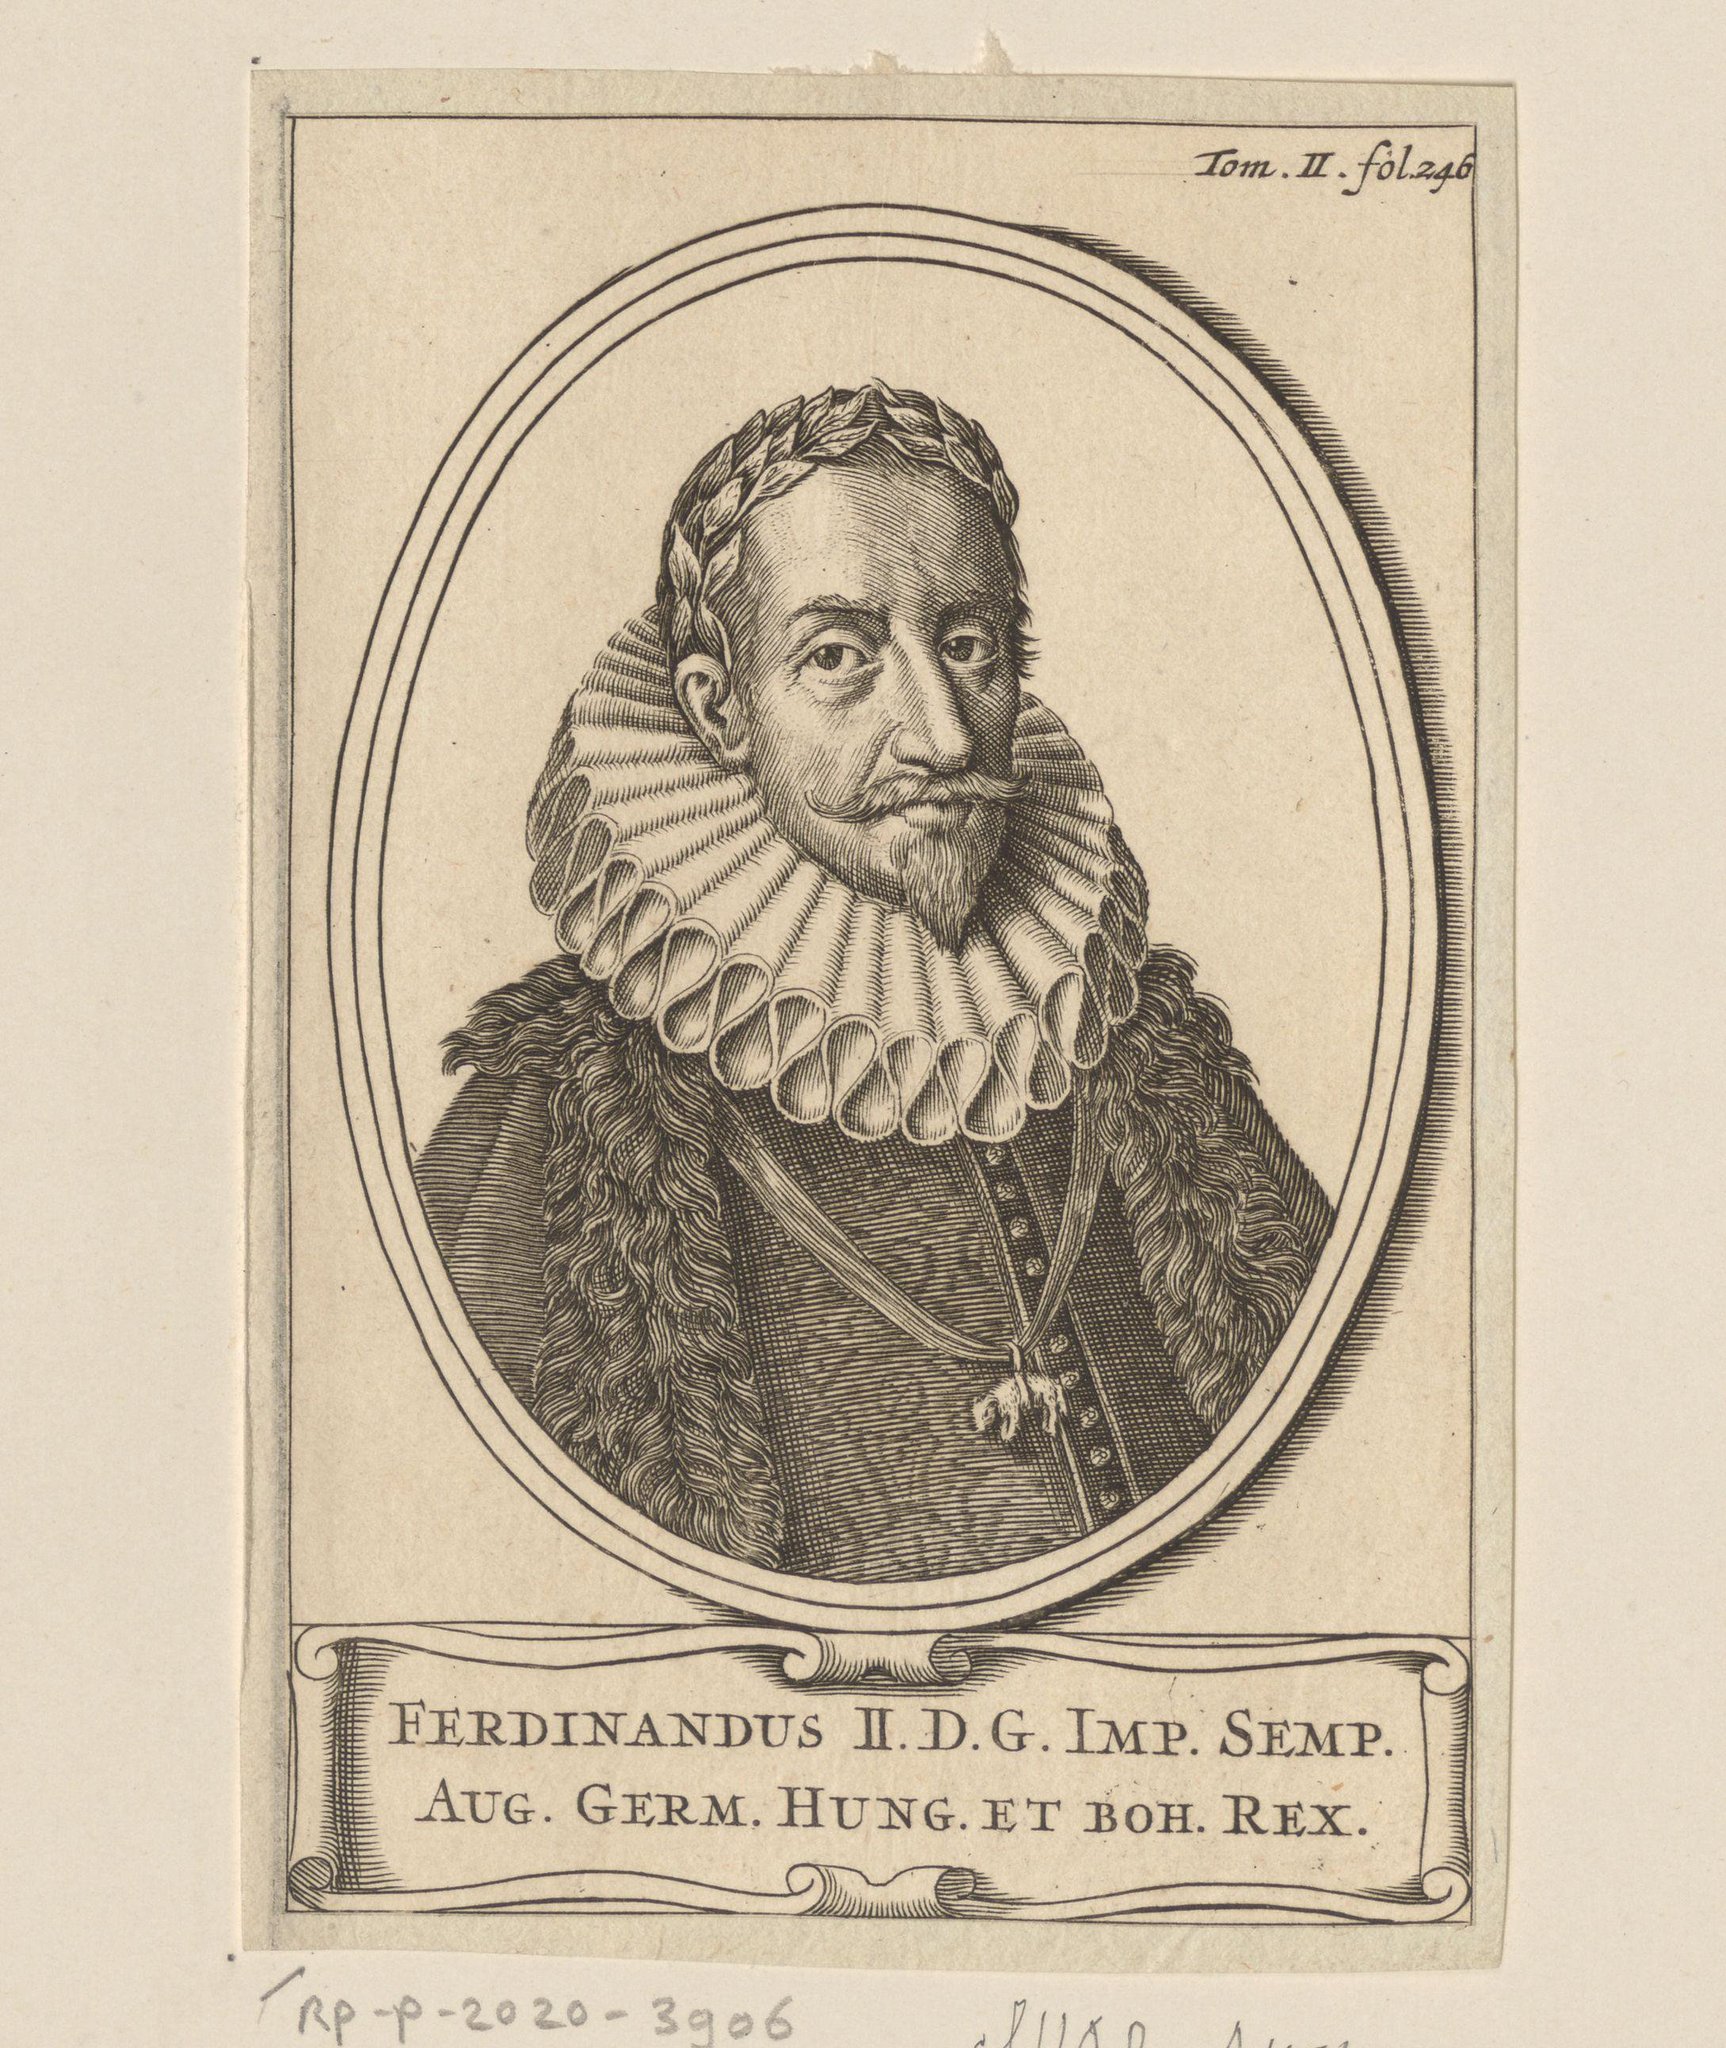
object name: print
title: Portret van keizer Ferdinand II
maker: Anonymous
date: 1682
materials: paper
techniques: engraving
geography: germany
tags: vienna, ferdinand ii (duits keizer), historical persons, knighthood order of the golden fleece, emperor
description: Prent waarschijnlijk uit: Nani, Giovan Battista. Histoire De La Republique De Venise. Keulen: Pierre Marteau, 1682, dl. 2. Prent in een eerdere staat gebruikt in: Wassenbergh, Everhard. Duytsche Florus, begrypende de Duytsche oorlogen (…). Amsterdam: Nicolaes van Ravesteyn, 1647.